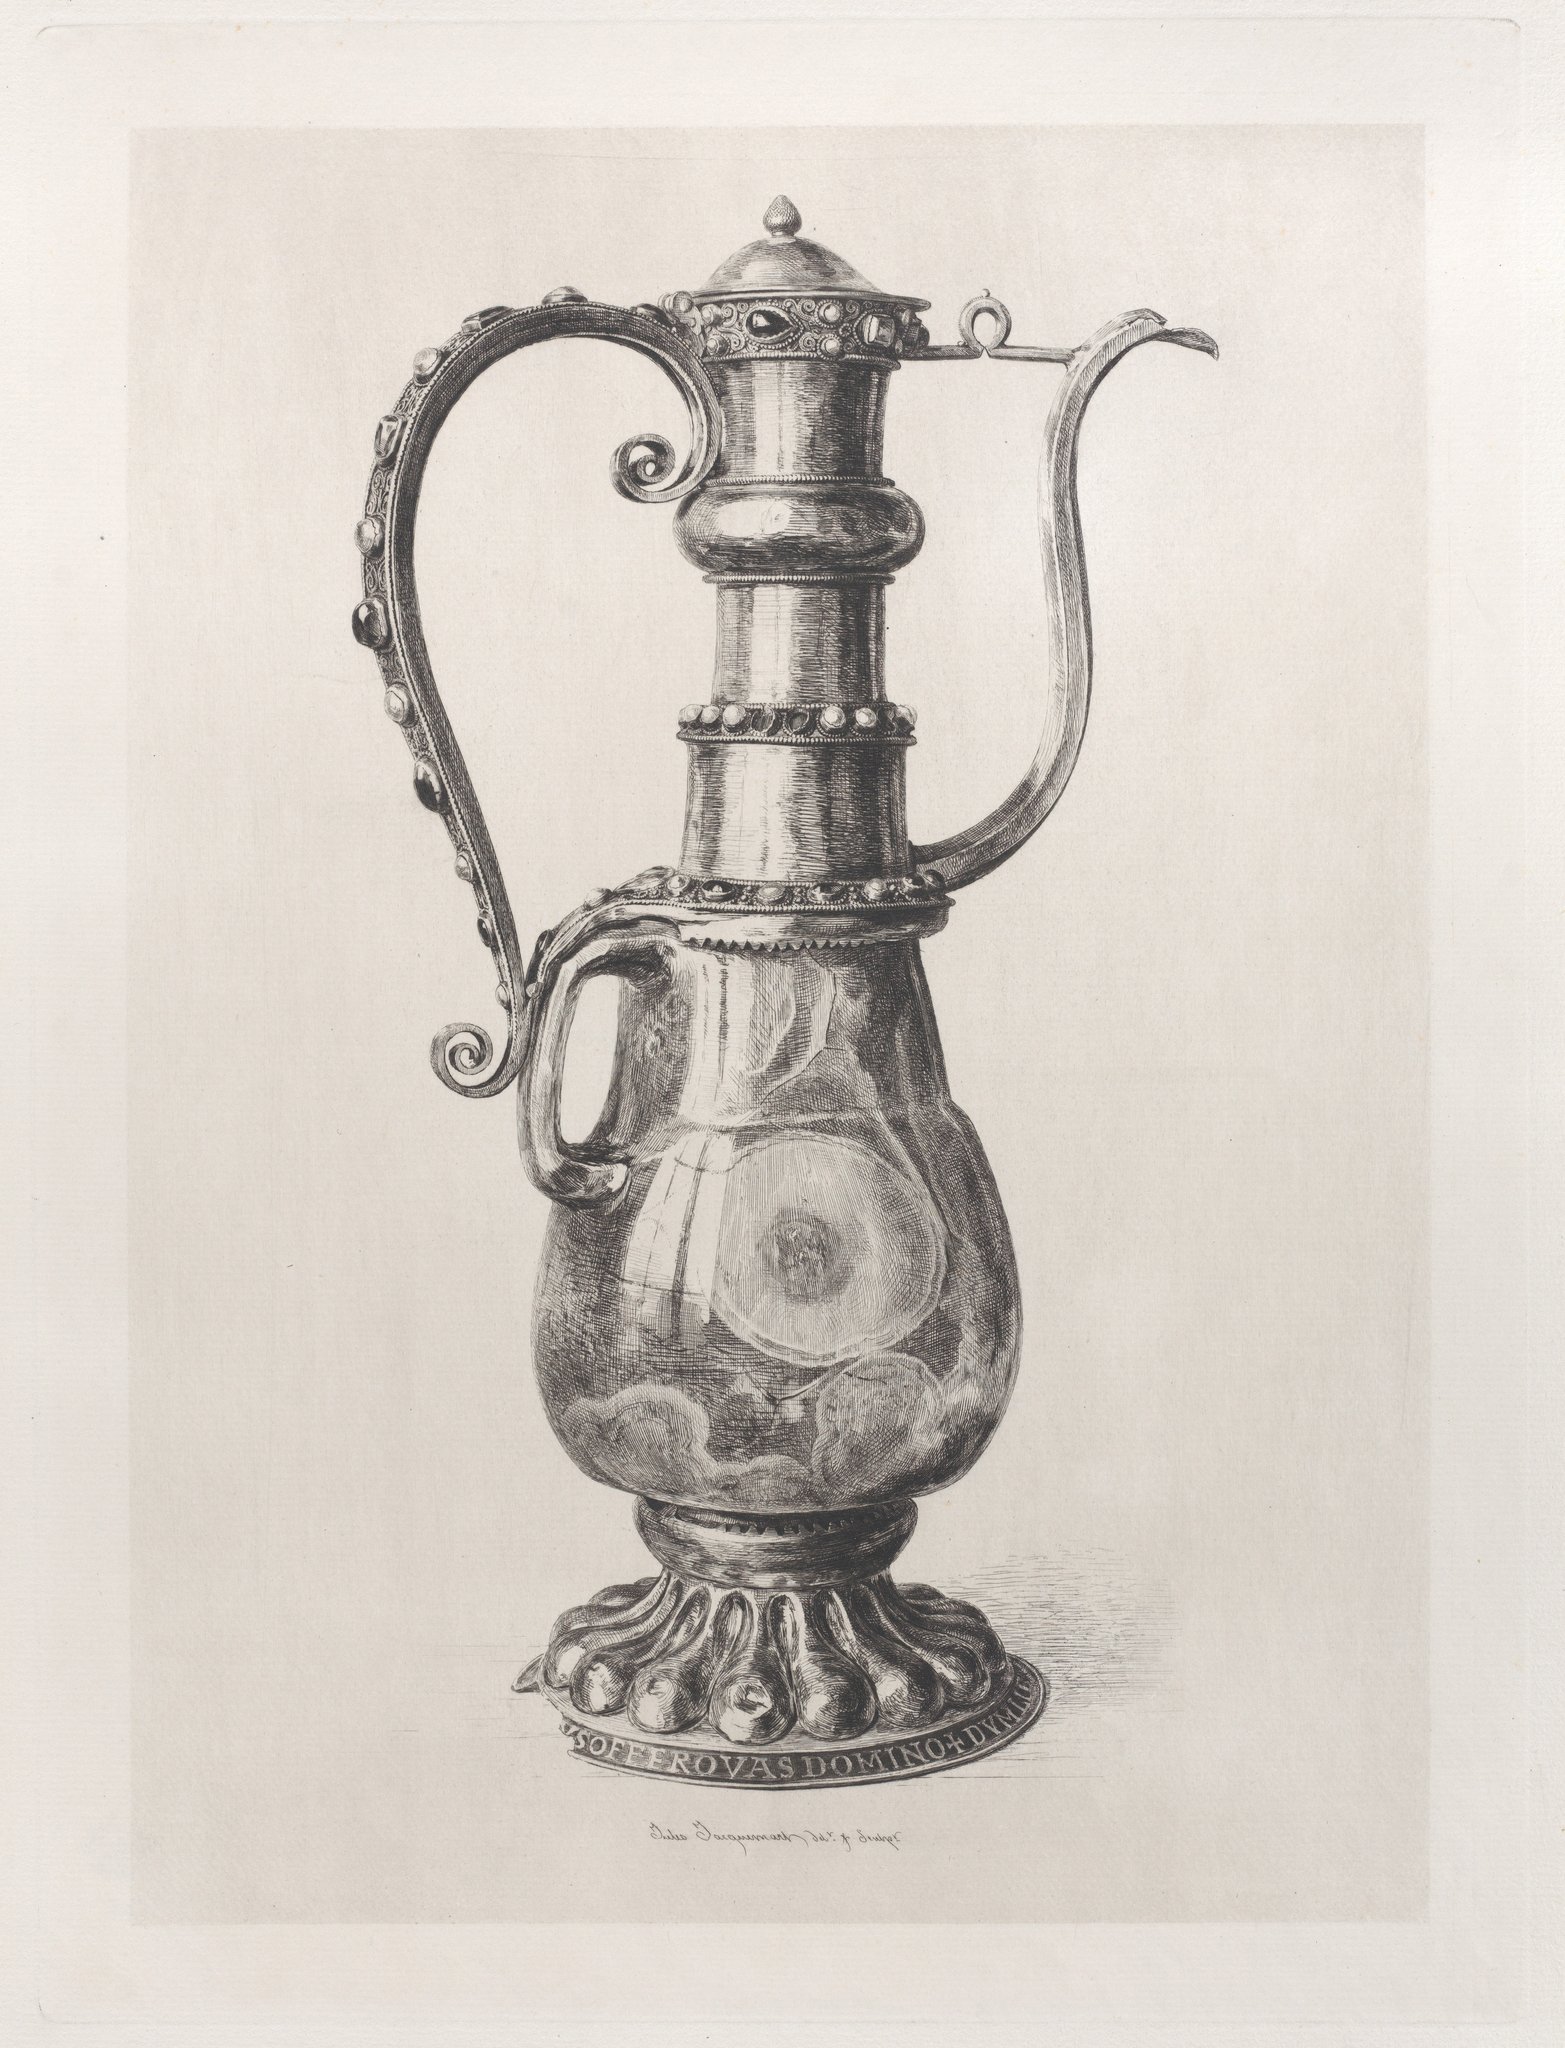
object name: print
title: Antique Sardonyx Vase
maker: jules-ferdinand jacquemart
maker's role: artist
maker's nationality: french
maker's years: 1837-1880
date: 1864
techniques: etching